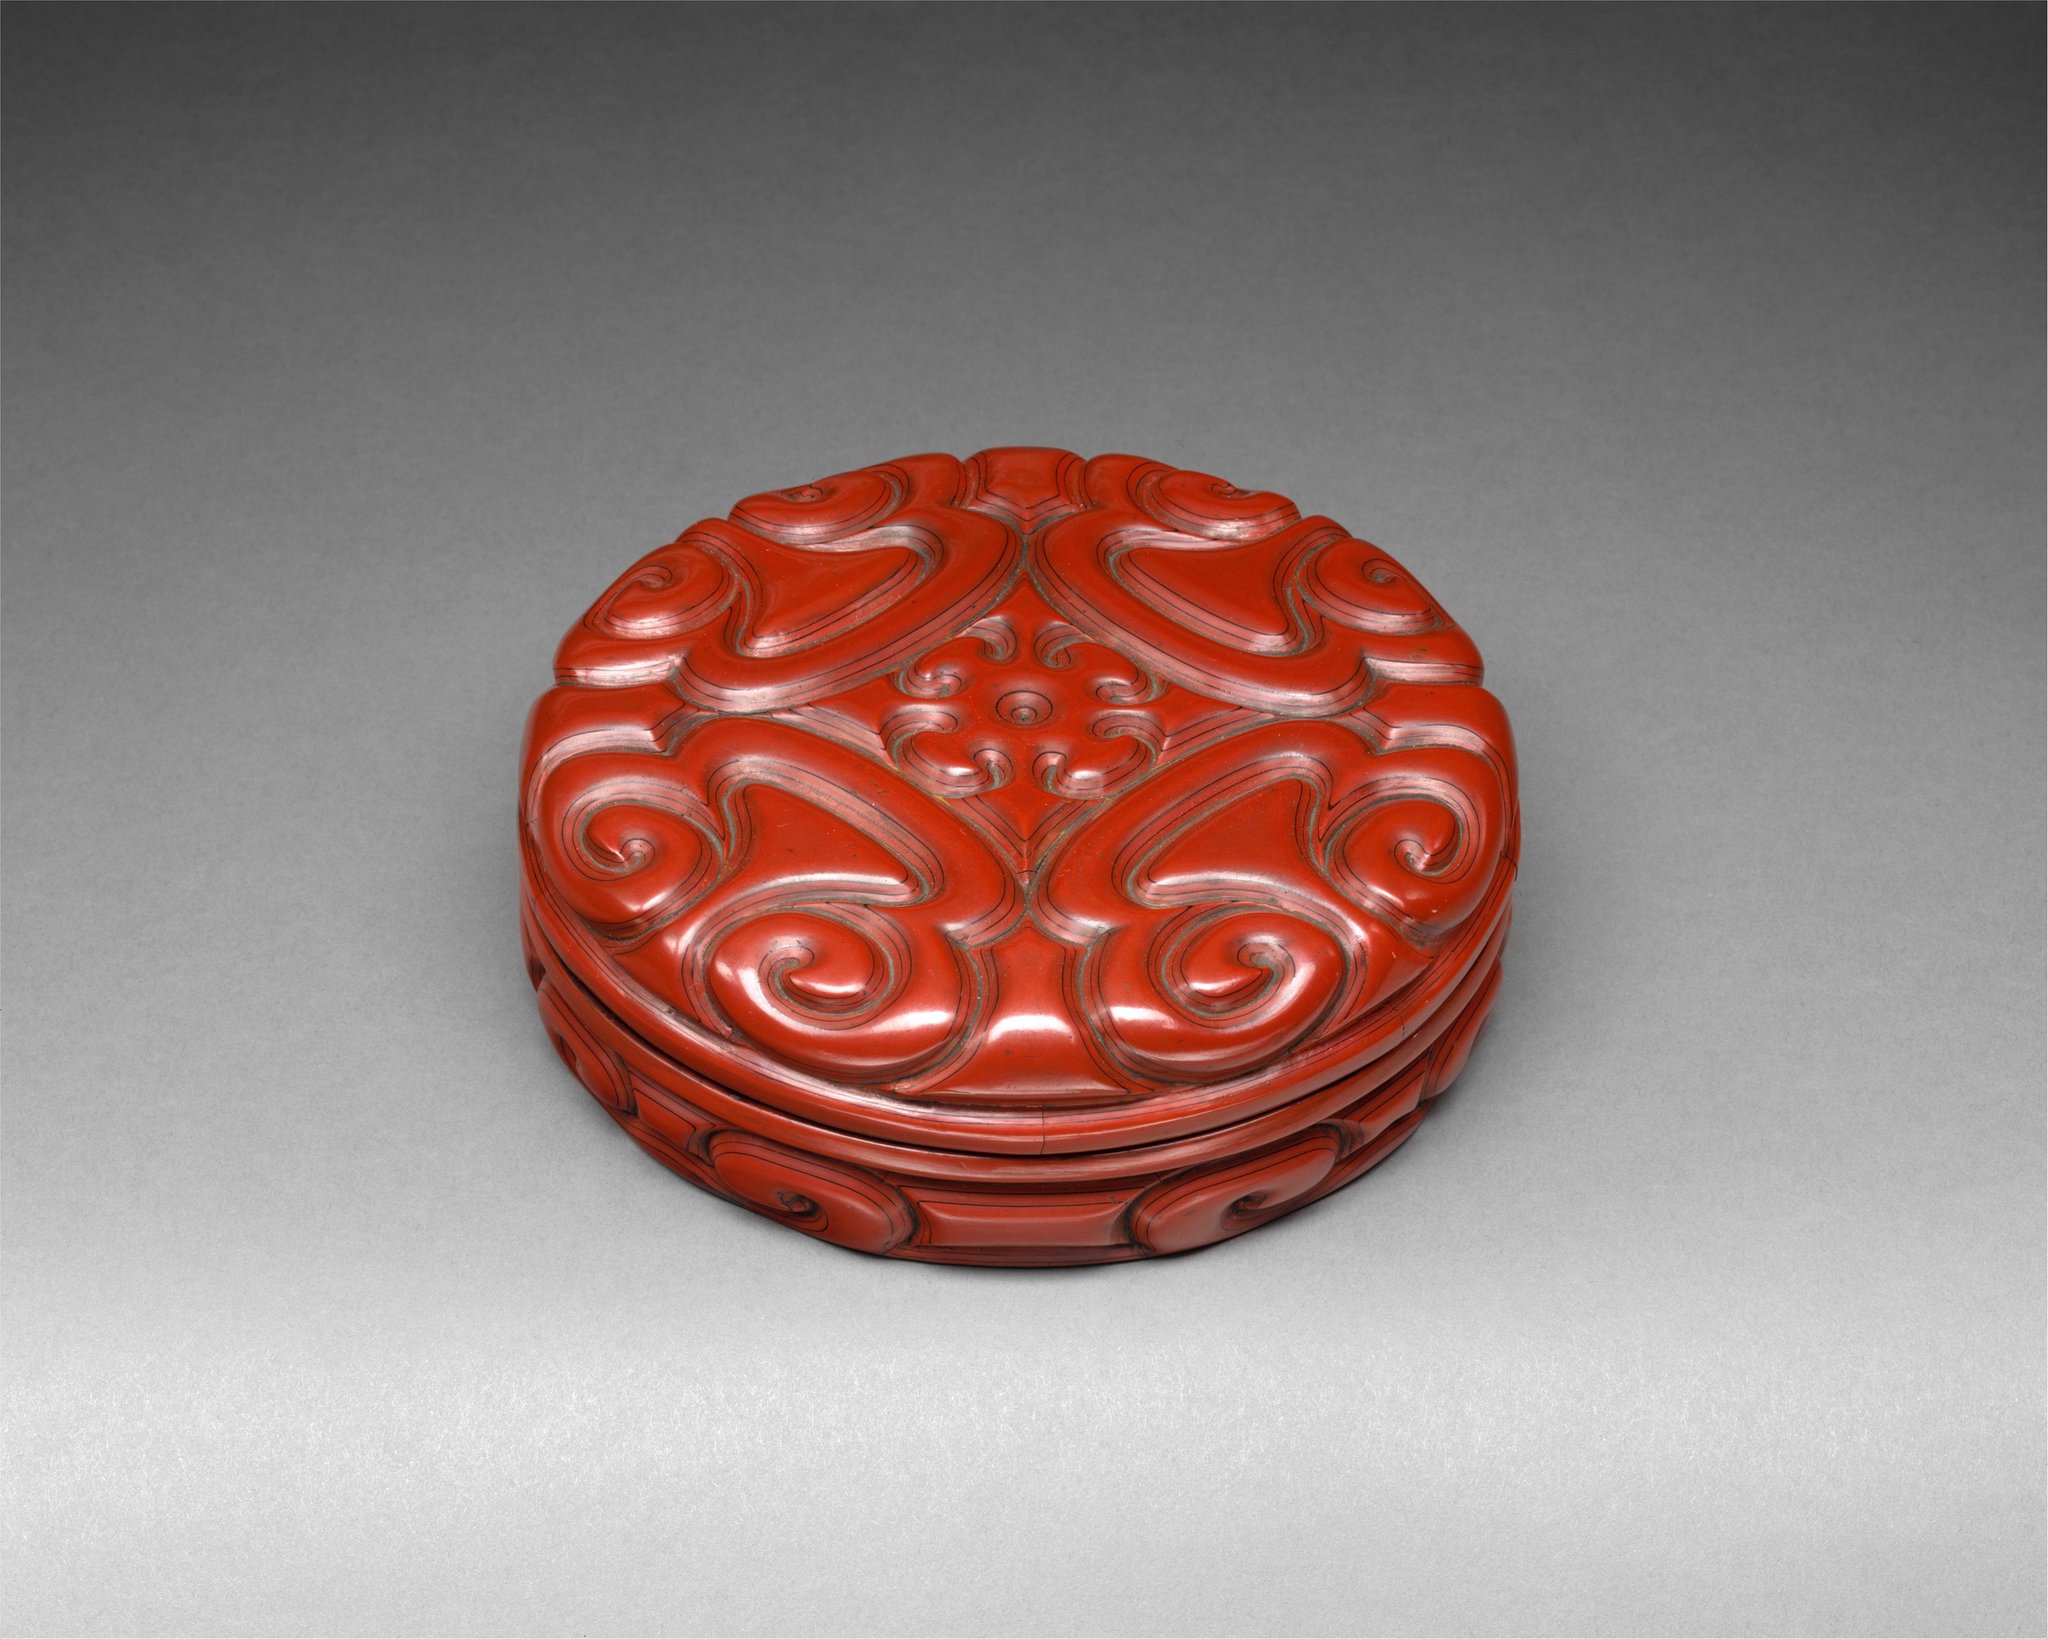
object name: box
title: Box with pommel scroll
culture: chinese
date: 1267-1400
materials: lacquer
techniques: carving